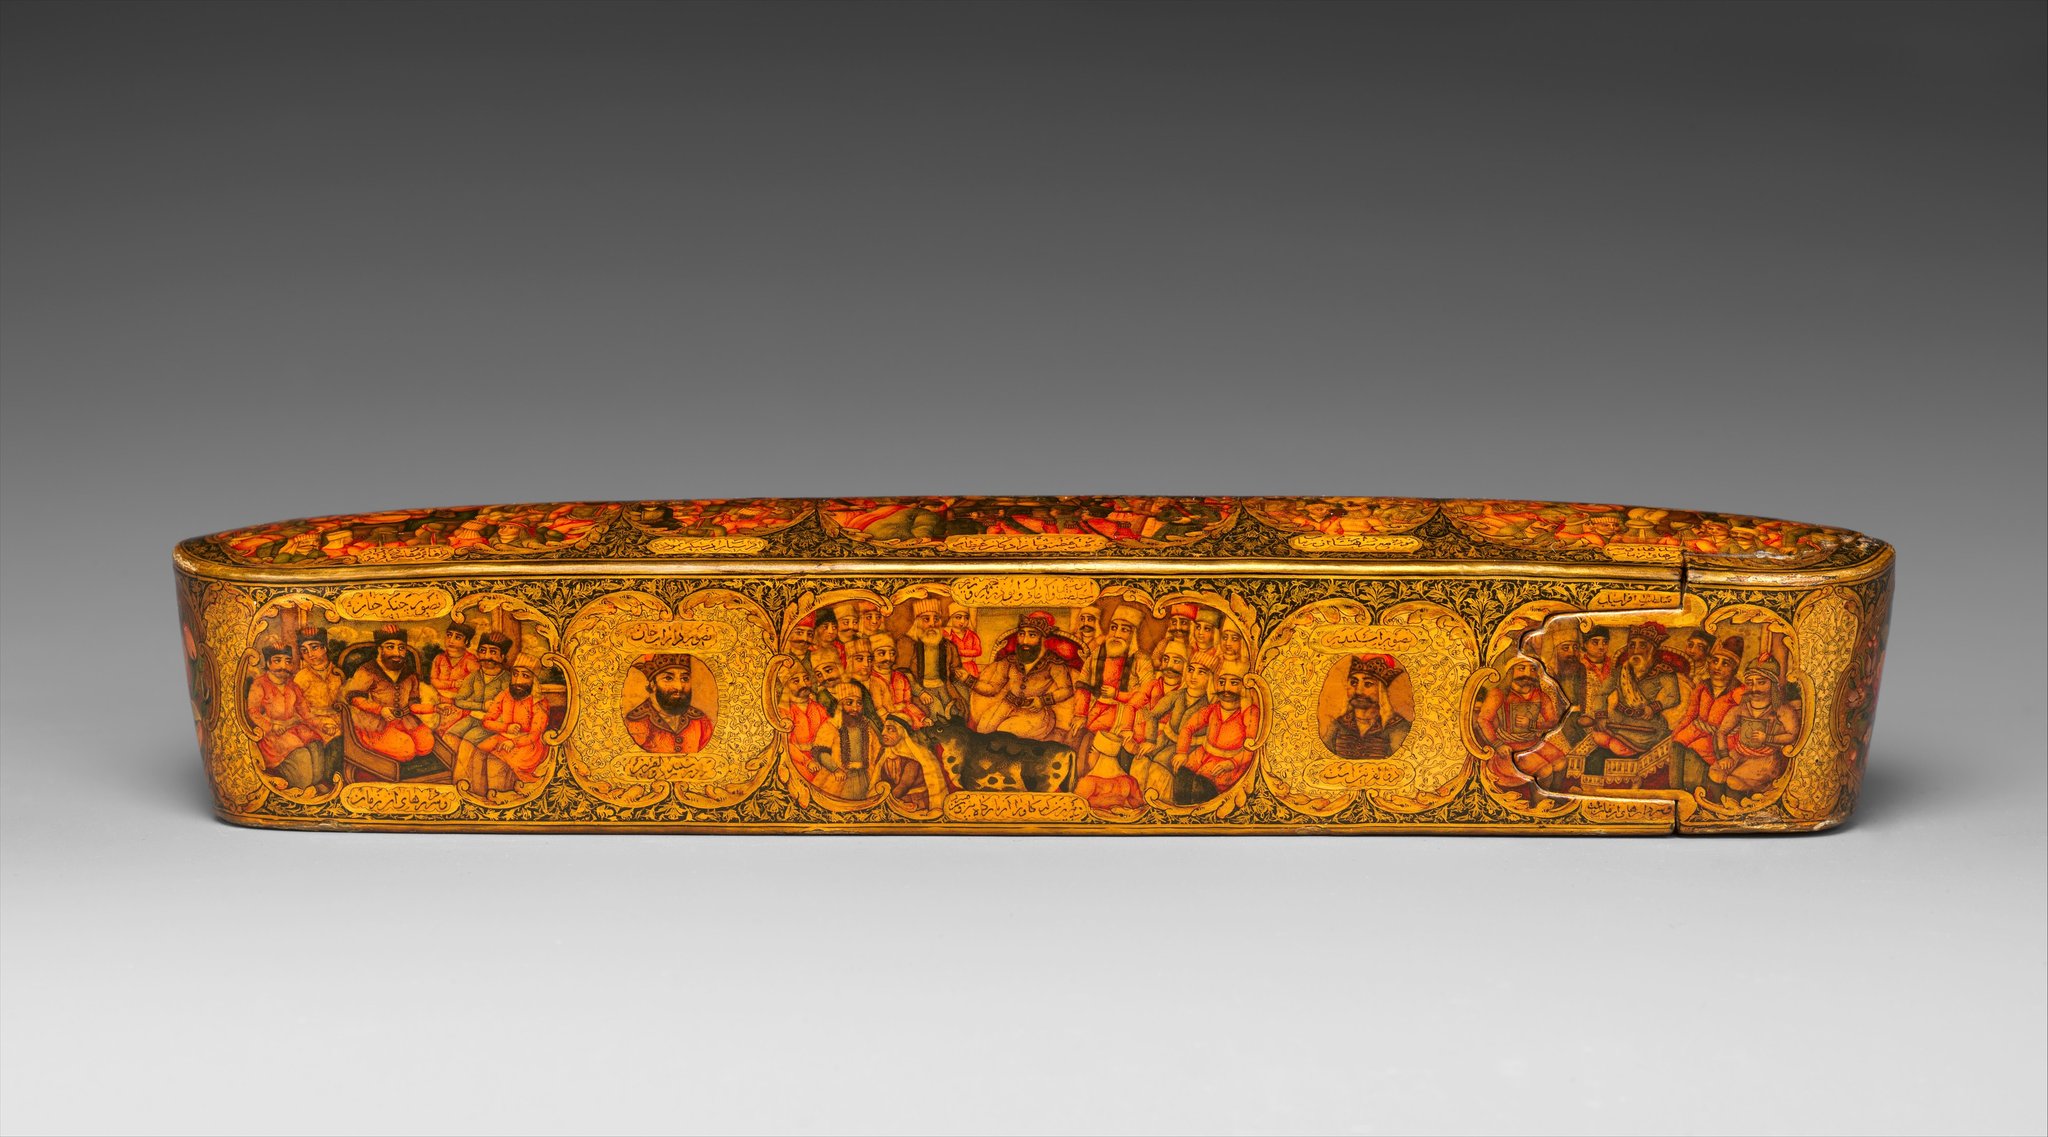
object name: pen box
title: Lacquer Pen Box with Royal Audience Scenes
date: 1870-1890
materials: paper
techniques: lacquer, painting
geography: iran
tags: kings,portraits